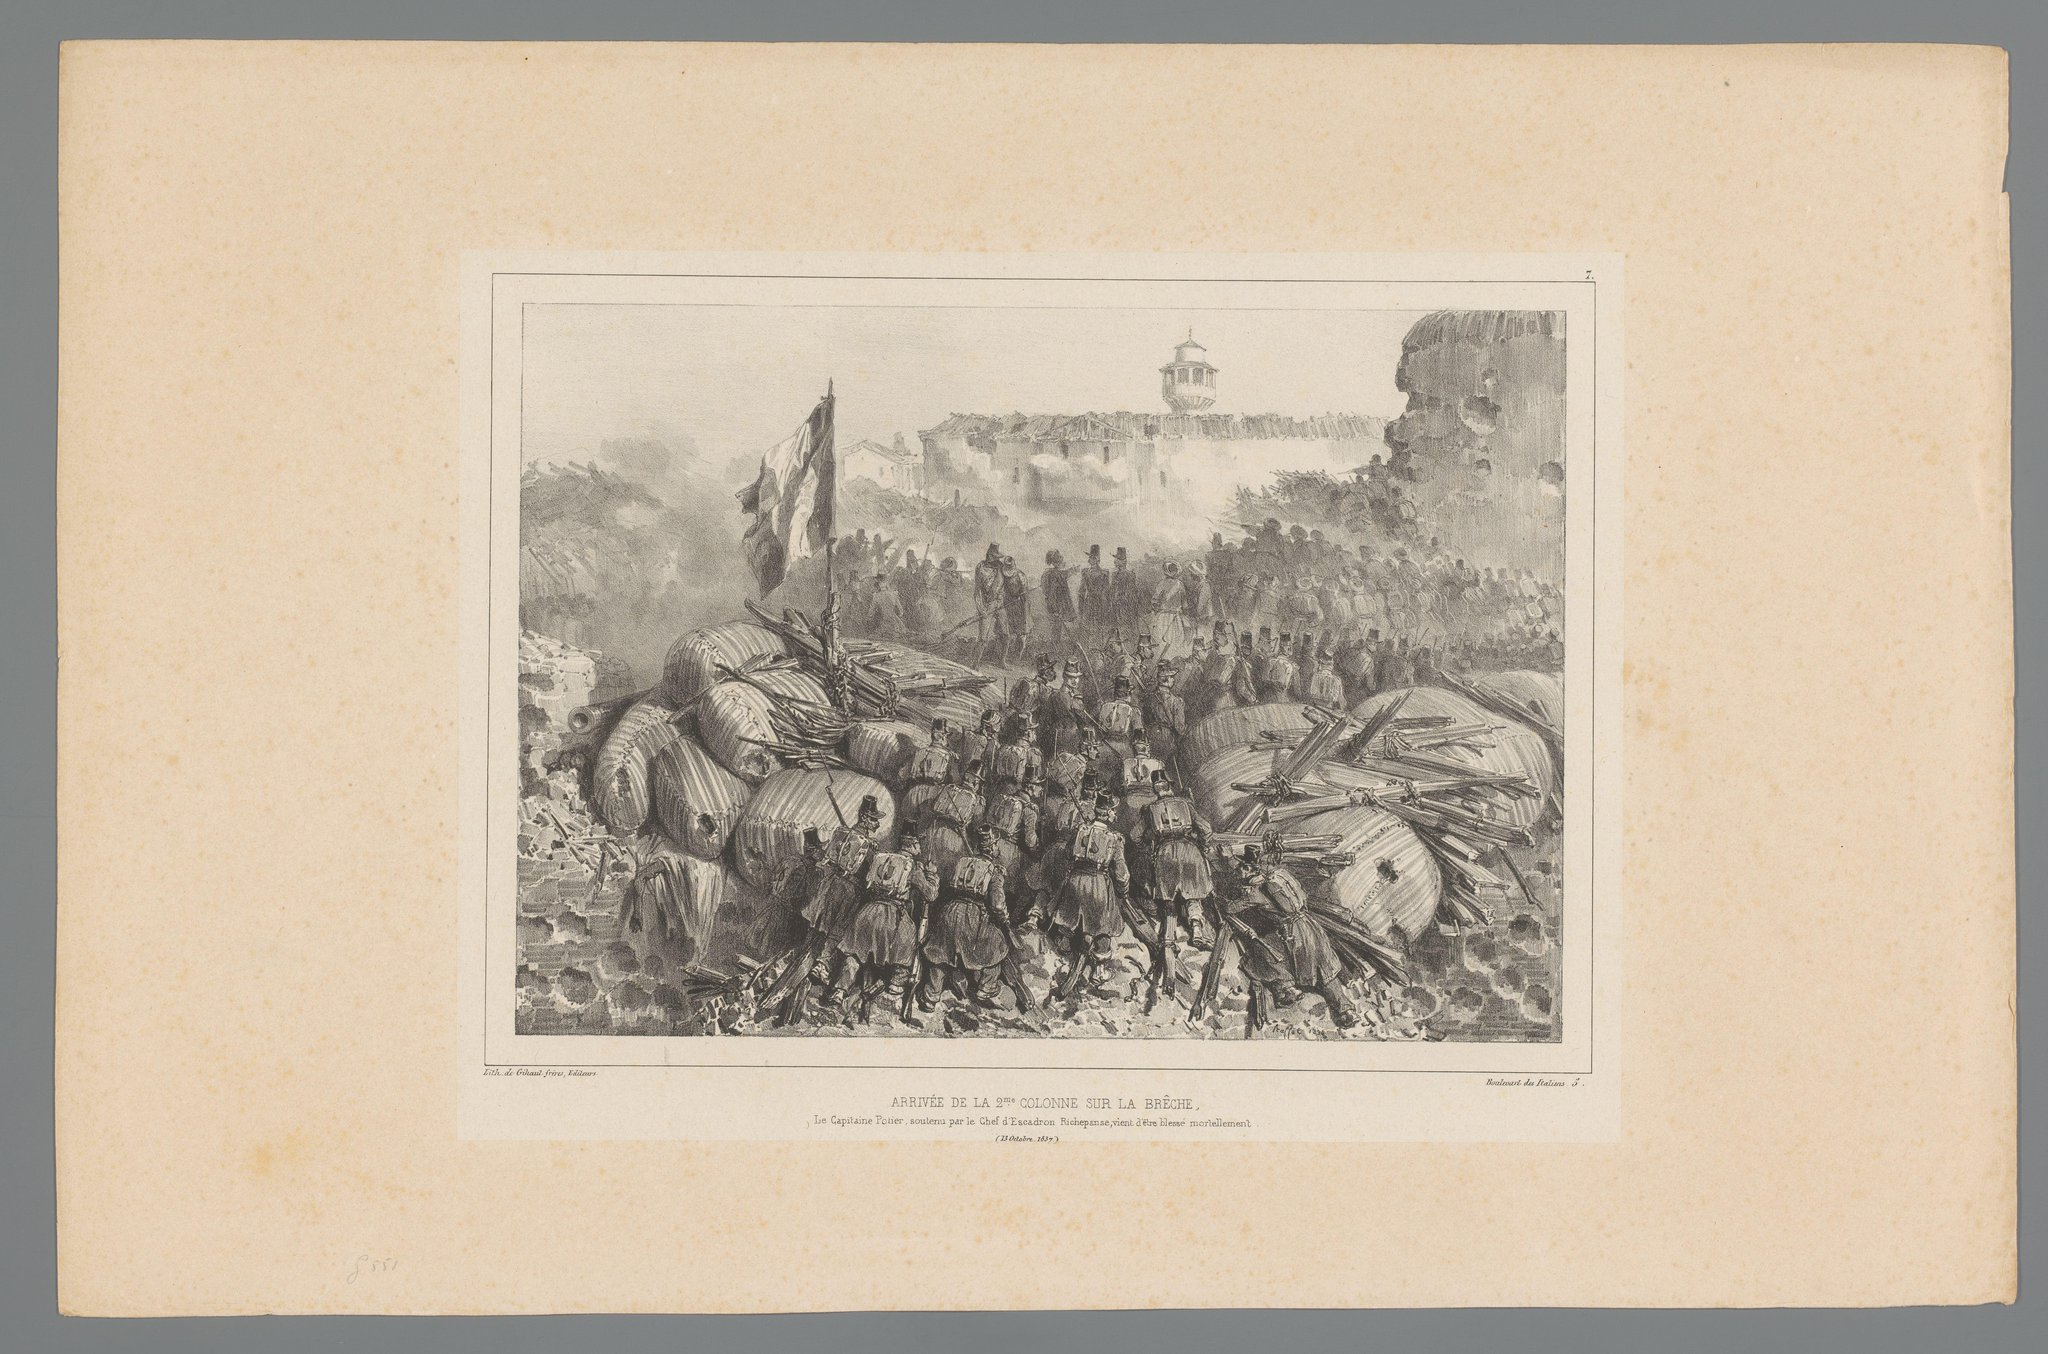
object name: print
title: Prise de Constantine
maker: denis auguste marie raffet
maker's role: draughtsman, print maker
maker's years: 1804-1860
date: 1838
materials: paper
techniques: lithograph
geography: paris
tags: siege, position war, the soldier; the soldier's life, devastated, ruined place or city (~ warfare)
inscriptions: collector's mark: Lugt 964